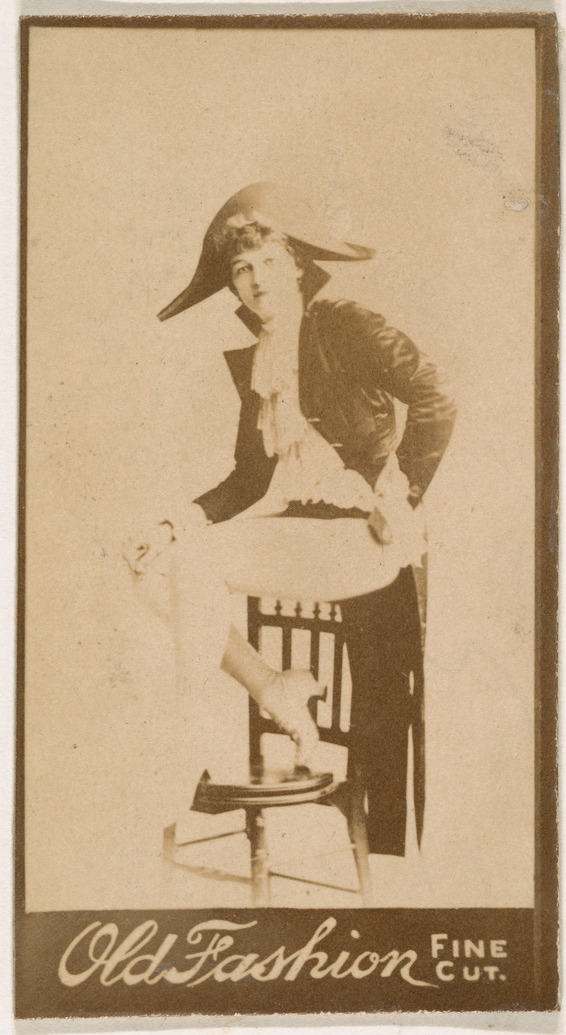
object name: photograph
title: Seated actress wearing military-inspired costume, from the Actresses series (N664) promoting Old Fashion Fine Cut Tobacco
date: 1888-1890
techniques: albumen silver print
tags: portraits,women,actresses